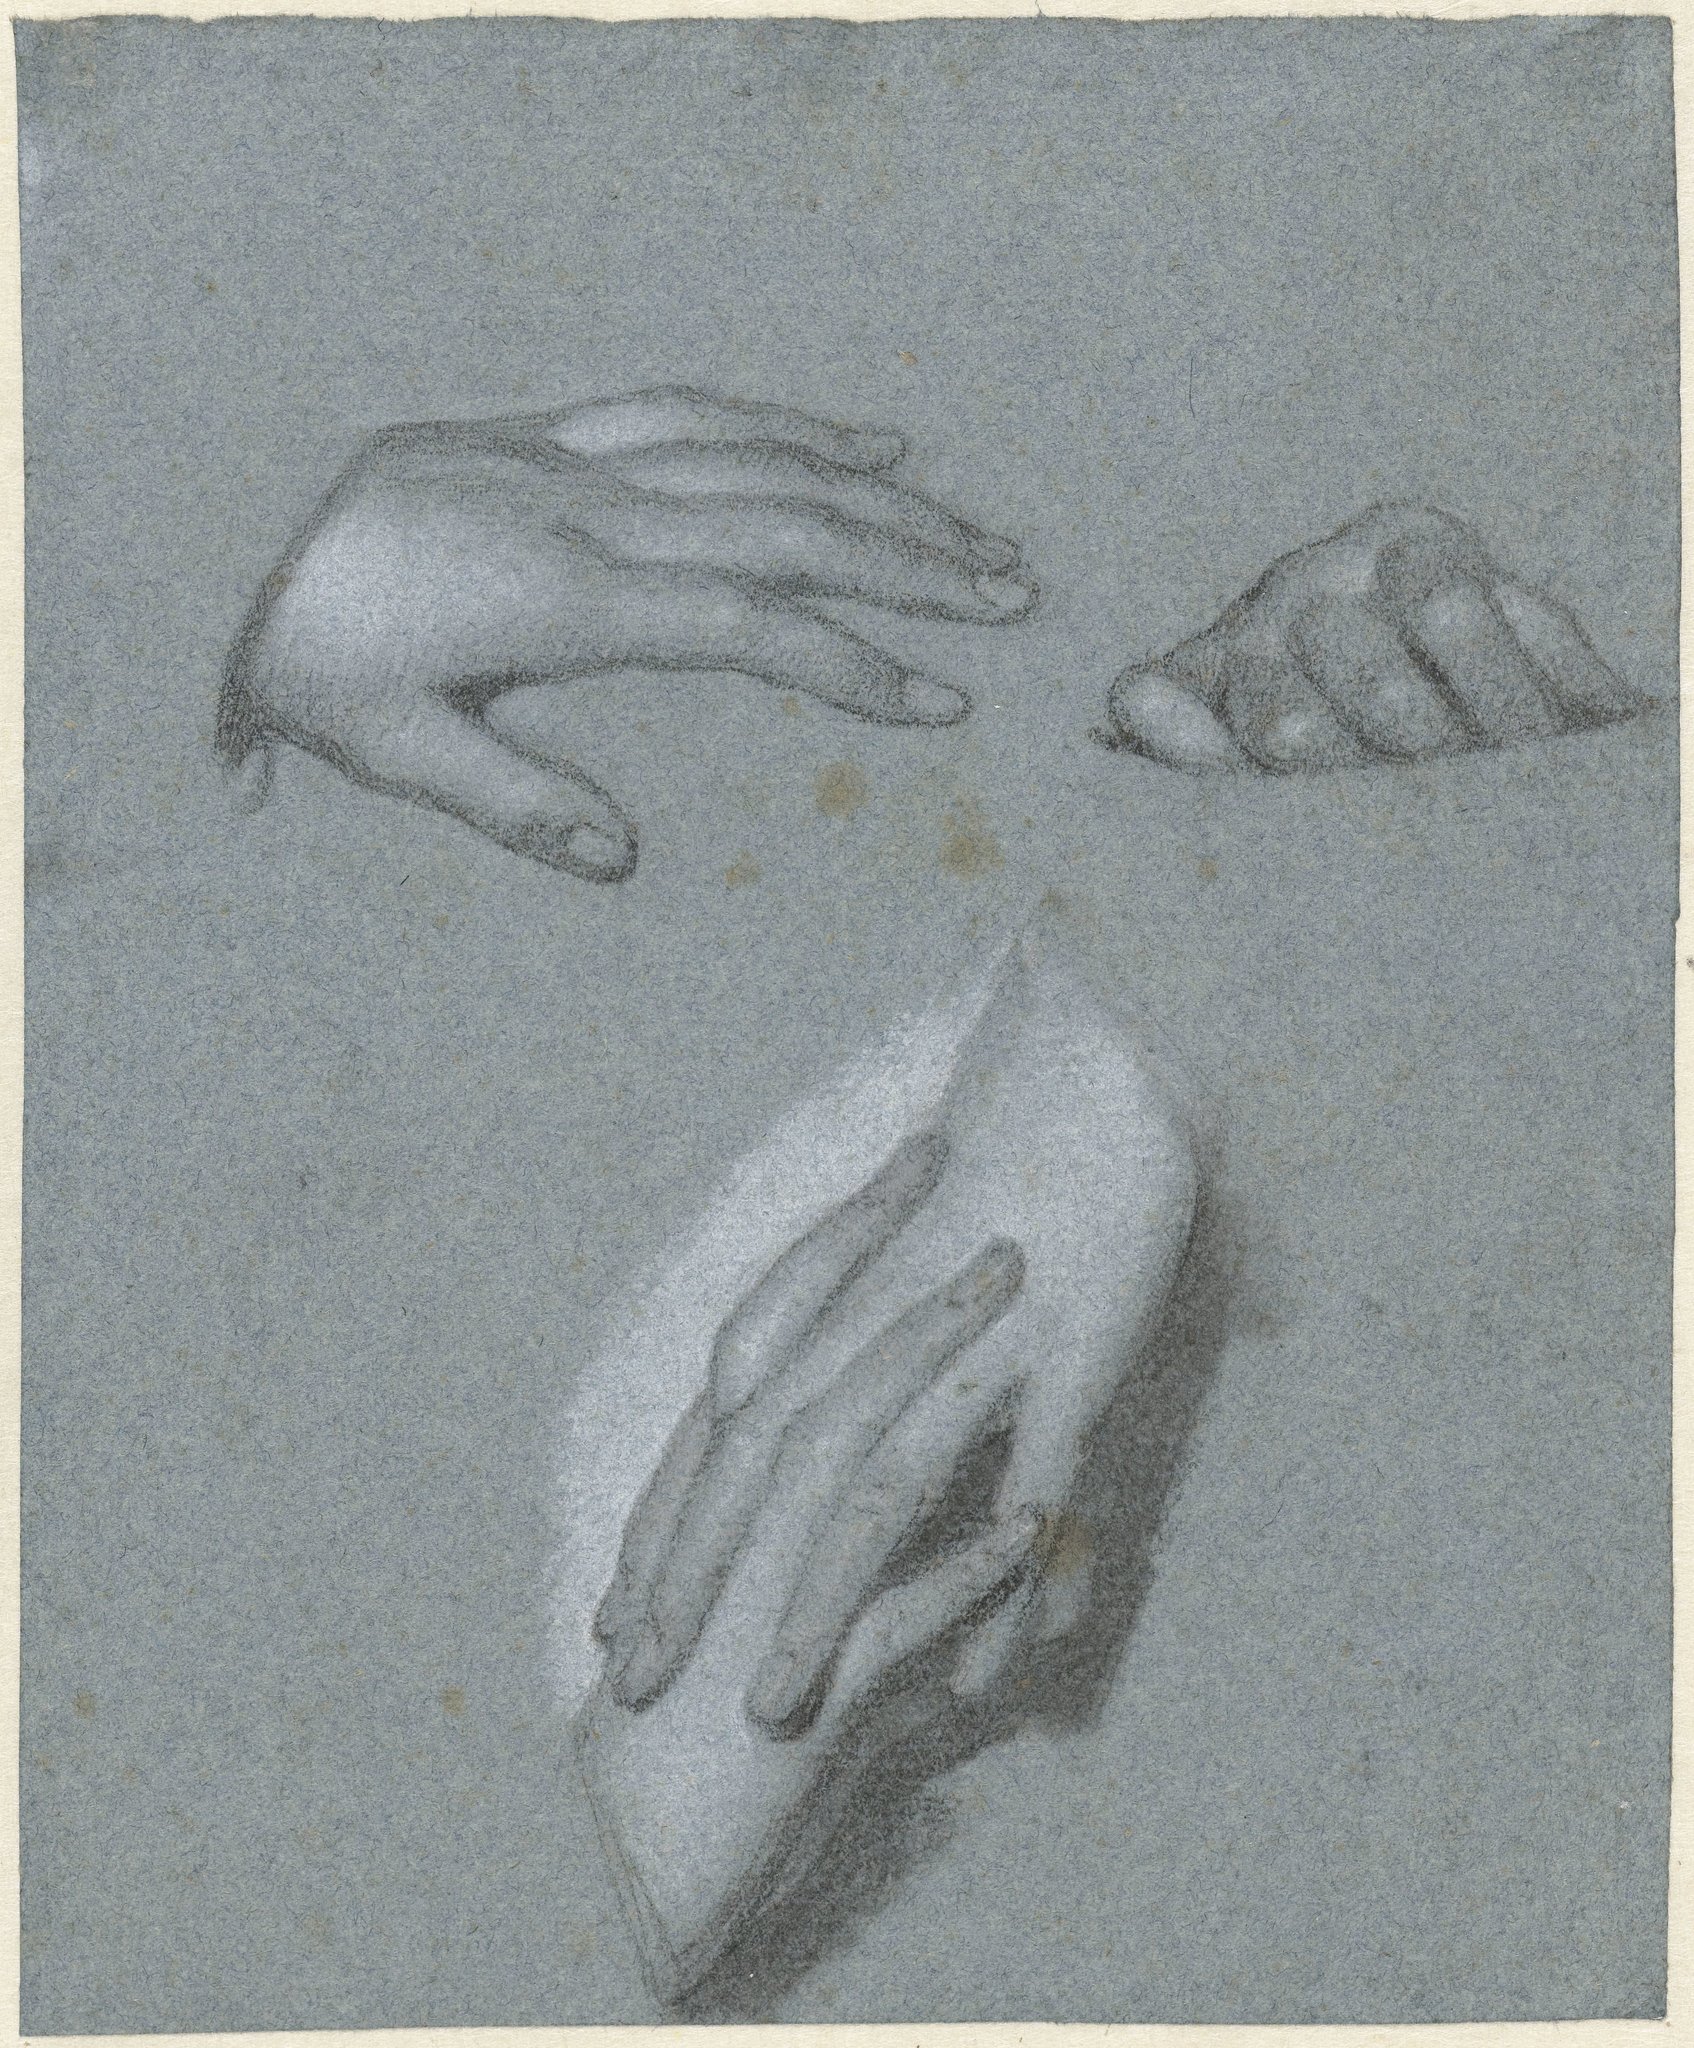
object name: drawing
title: Studies van handen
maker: charles howard hodges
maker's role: draughtsman, painter, print maker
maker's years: 1764-1837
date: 1774-1837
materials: chalk, paper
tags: hand